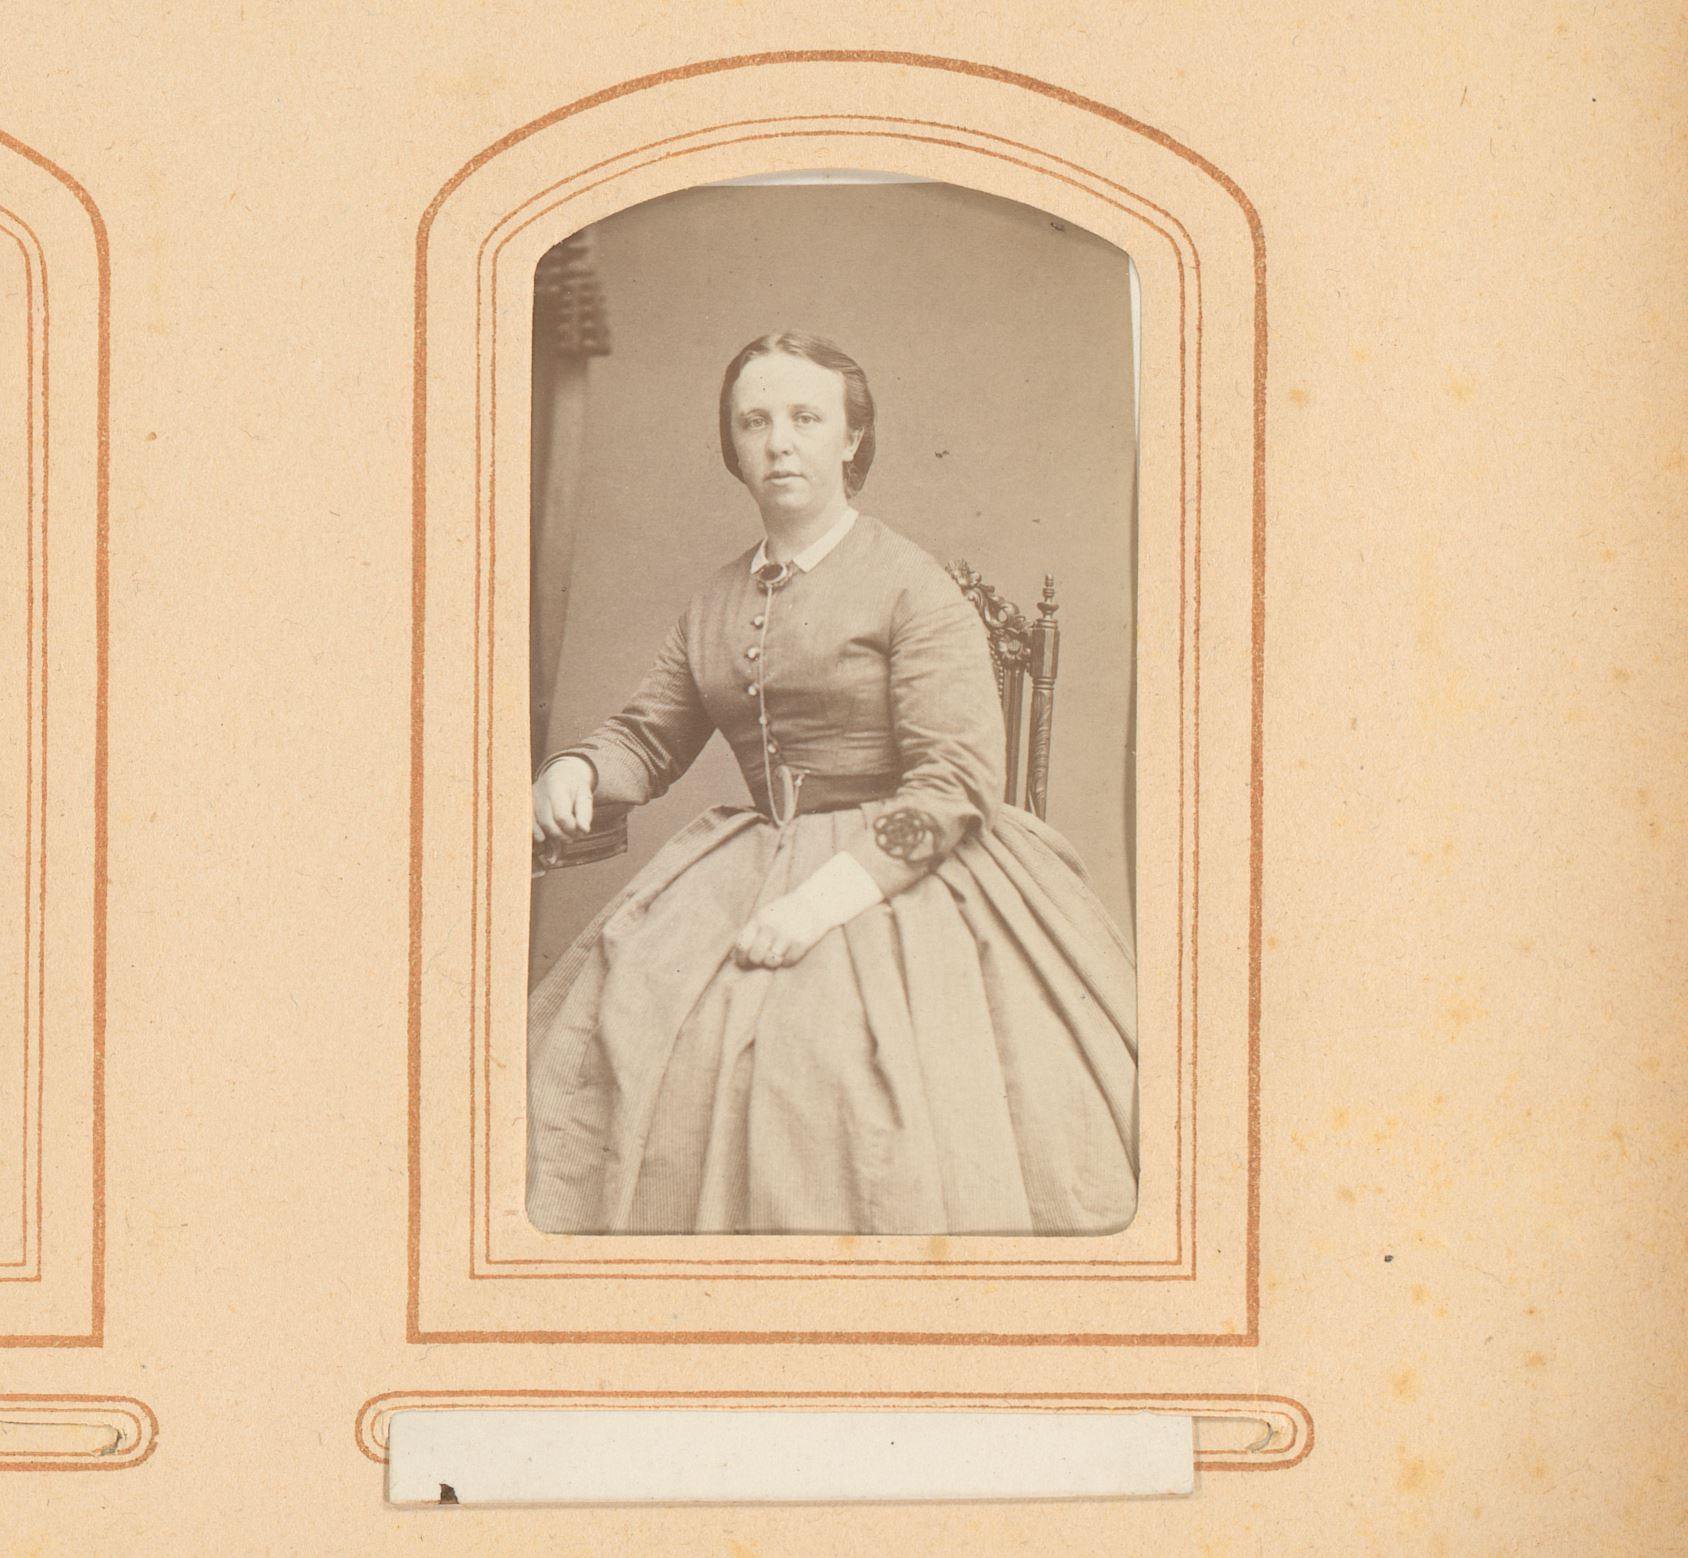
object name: carte de visite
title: Portret van een zittende vrouw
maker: a. jensen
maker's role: fotograaf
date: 1855-1890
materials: cardboard, photographic support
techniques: albumen print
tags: sitting figure - aa - female human figure, historical persons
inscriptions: annotation: ‘Hedda [...]lander’, annotation: ‘Fotografi-Atelier/ A. Jensen/ Drottinggatan N0. 29 A/ Stockholm’